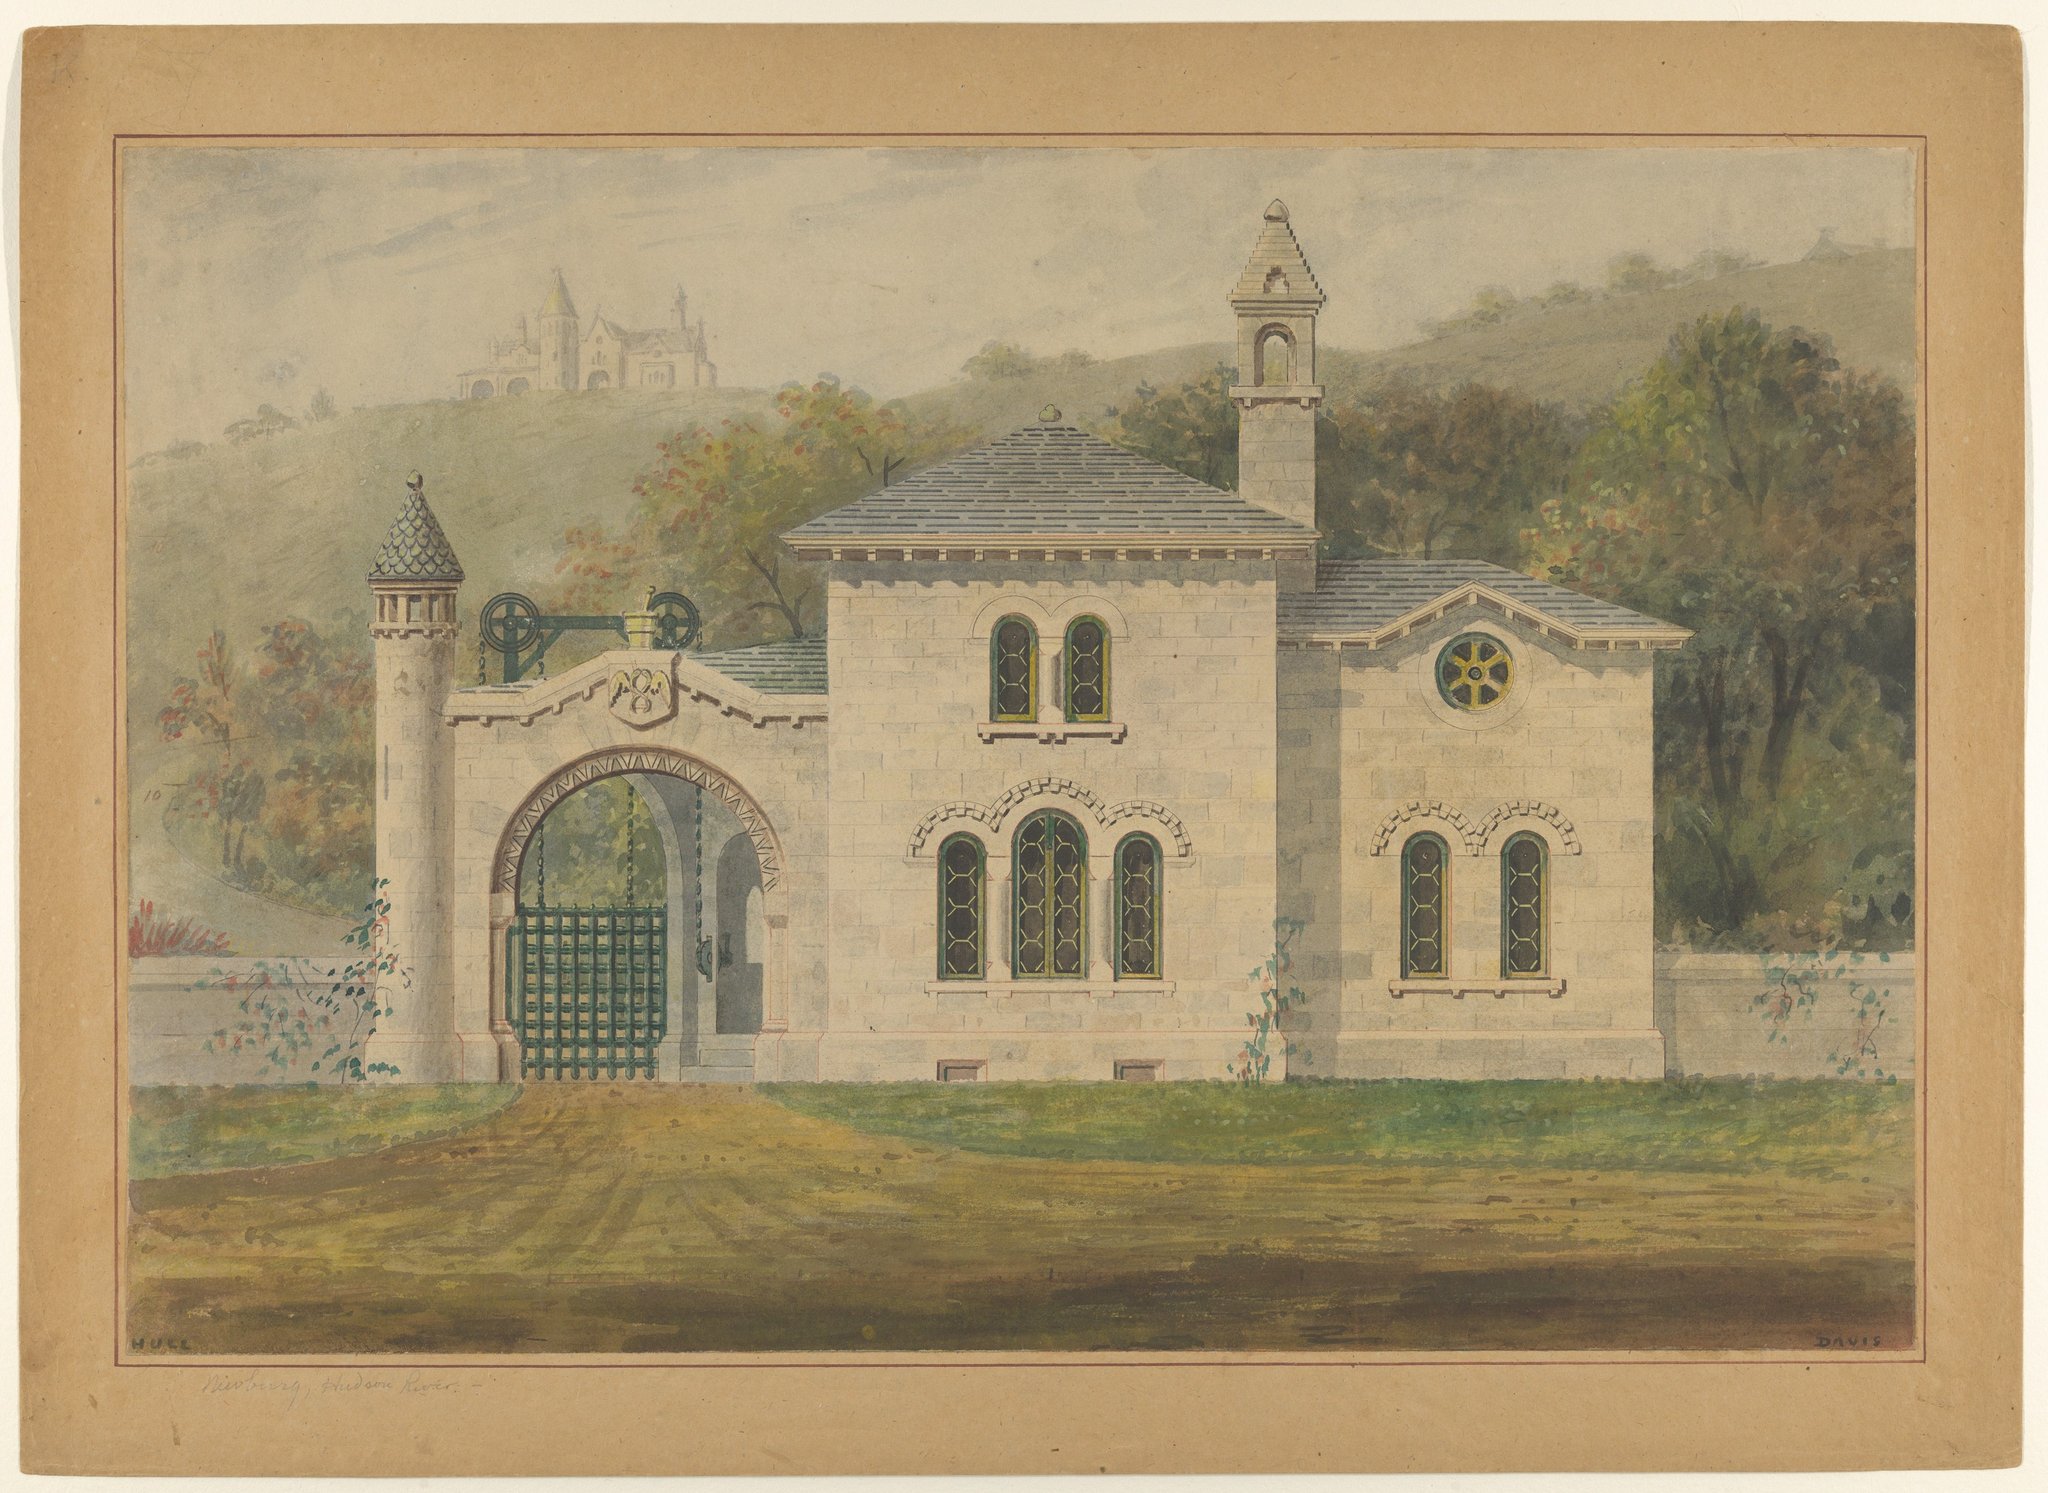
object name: drawing ornament architecture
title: Gate Lodge for Amos G. Hull, Newburgh, New York (front elevation)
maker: alexander jackson davis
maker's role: artist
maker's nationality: american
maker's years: 1803-1892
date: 1849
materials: graphite, ink, paper, watercolor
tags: architecture,buildings